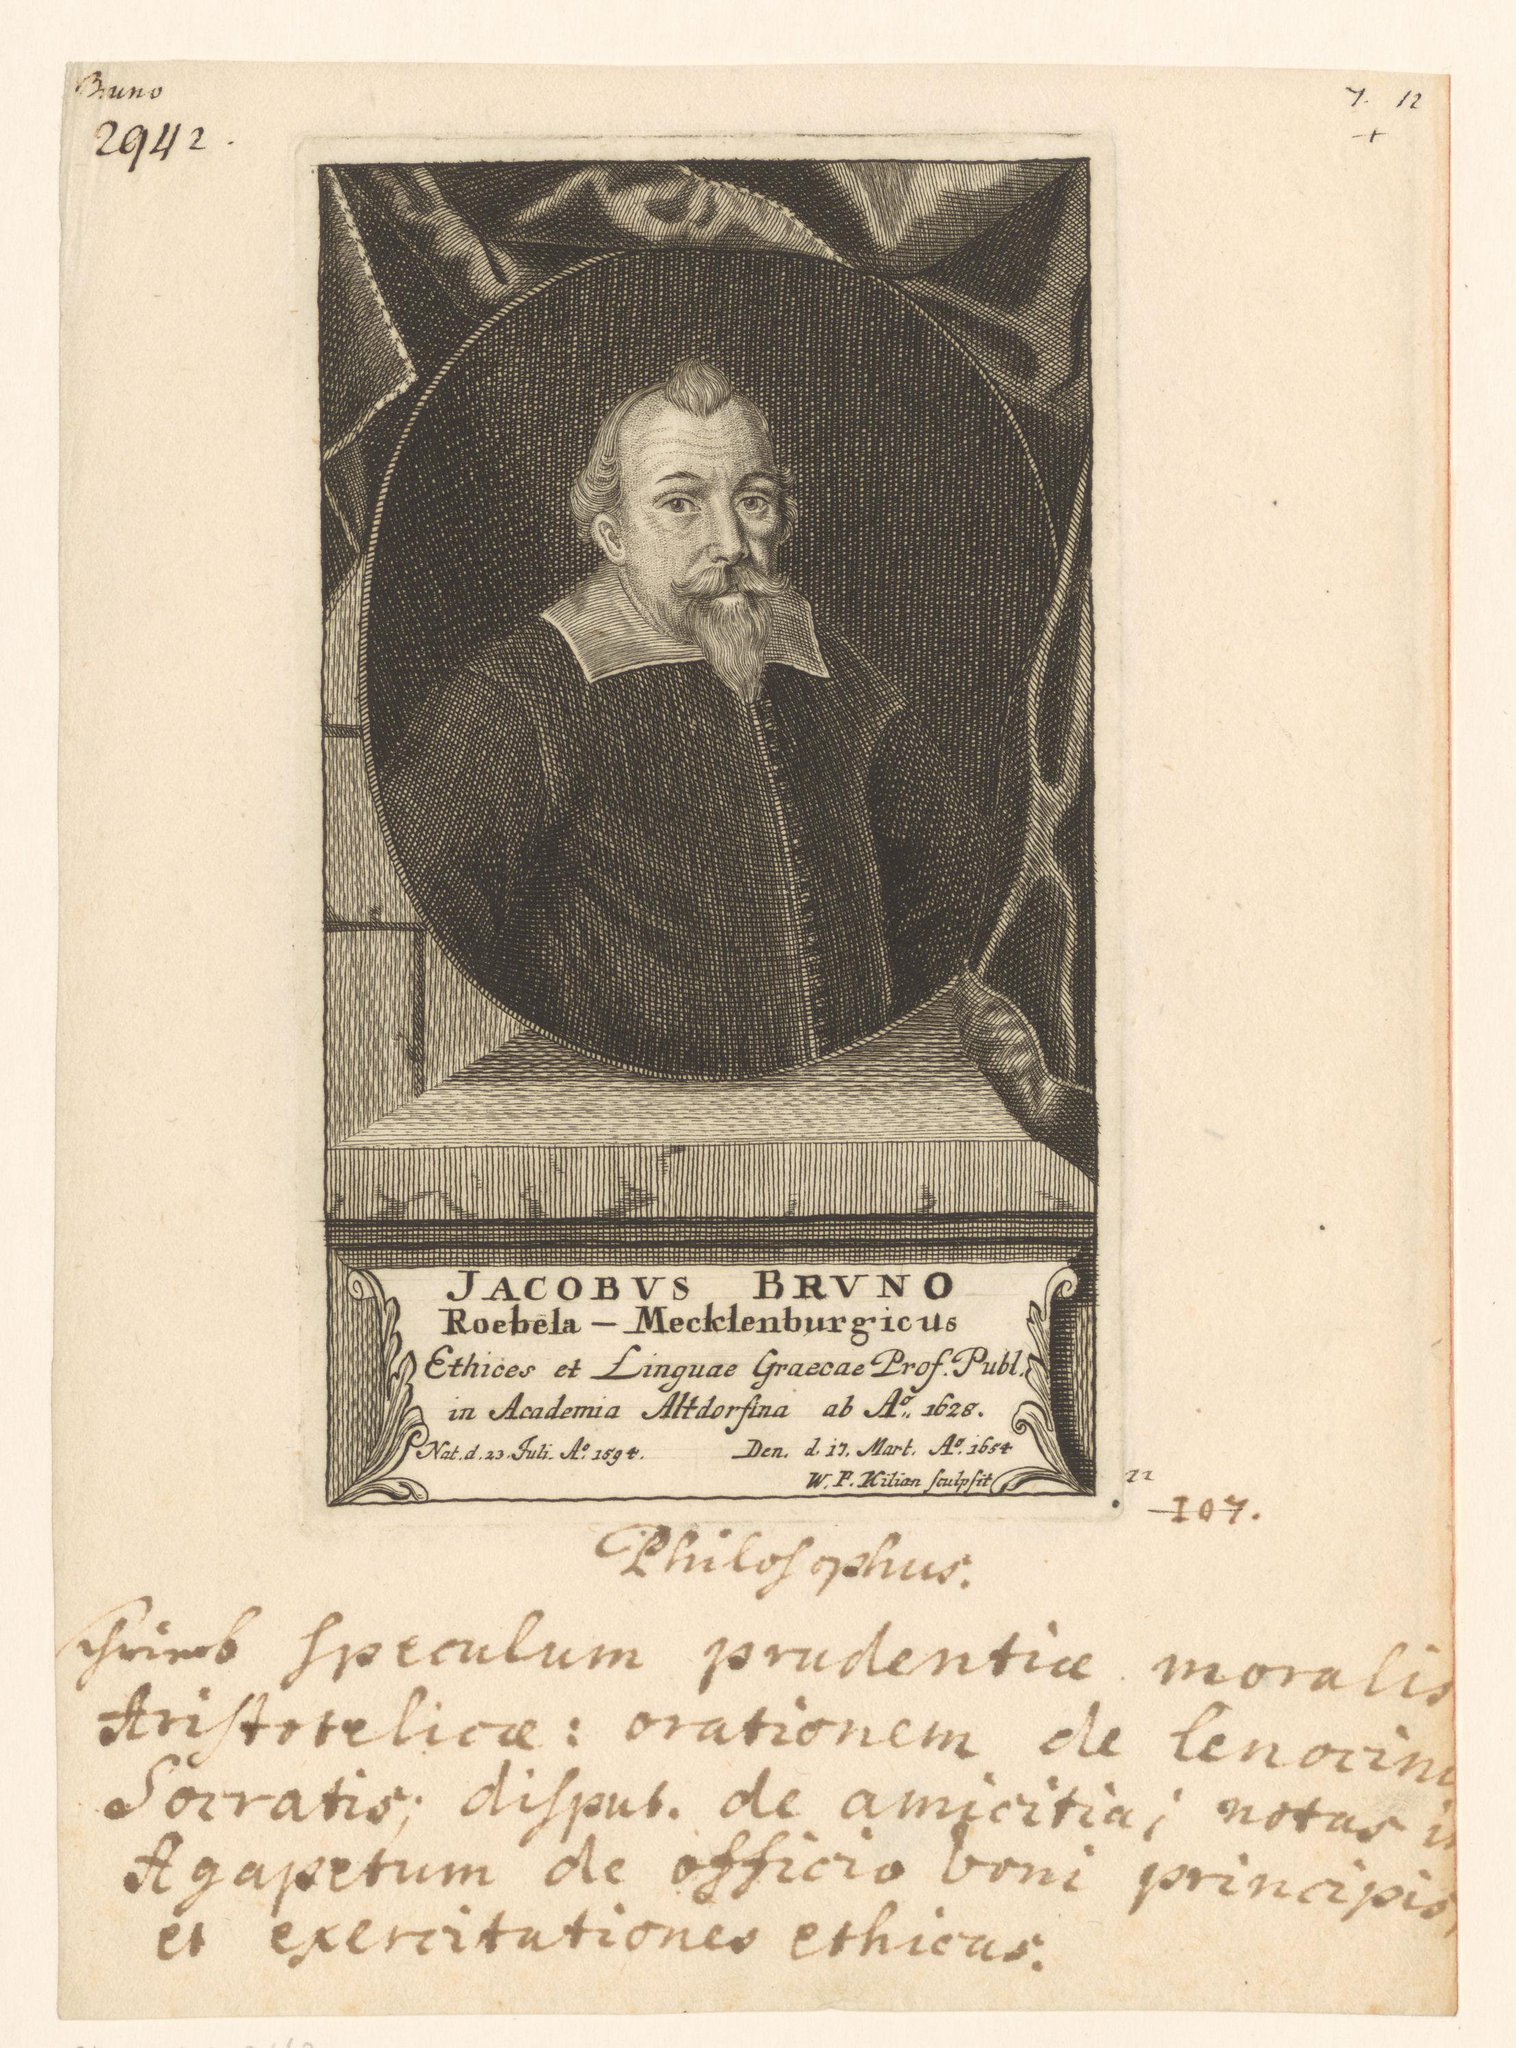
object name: print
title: Portret van Jacob Bruno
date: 1669-1728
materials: paper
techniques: engraving, etching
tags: further education (+ portrait of teacher, professor), historical persons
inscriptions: annotation: ‘Philosophus Jacob speculum prudentiae moarlis Aristoteliae: orationem de (...) ethicus.’, number: ‘2942’, collector's mark: Lugt 2228